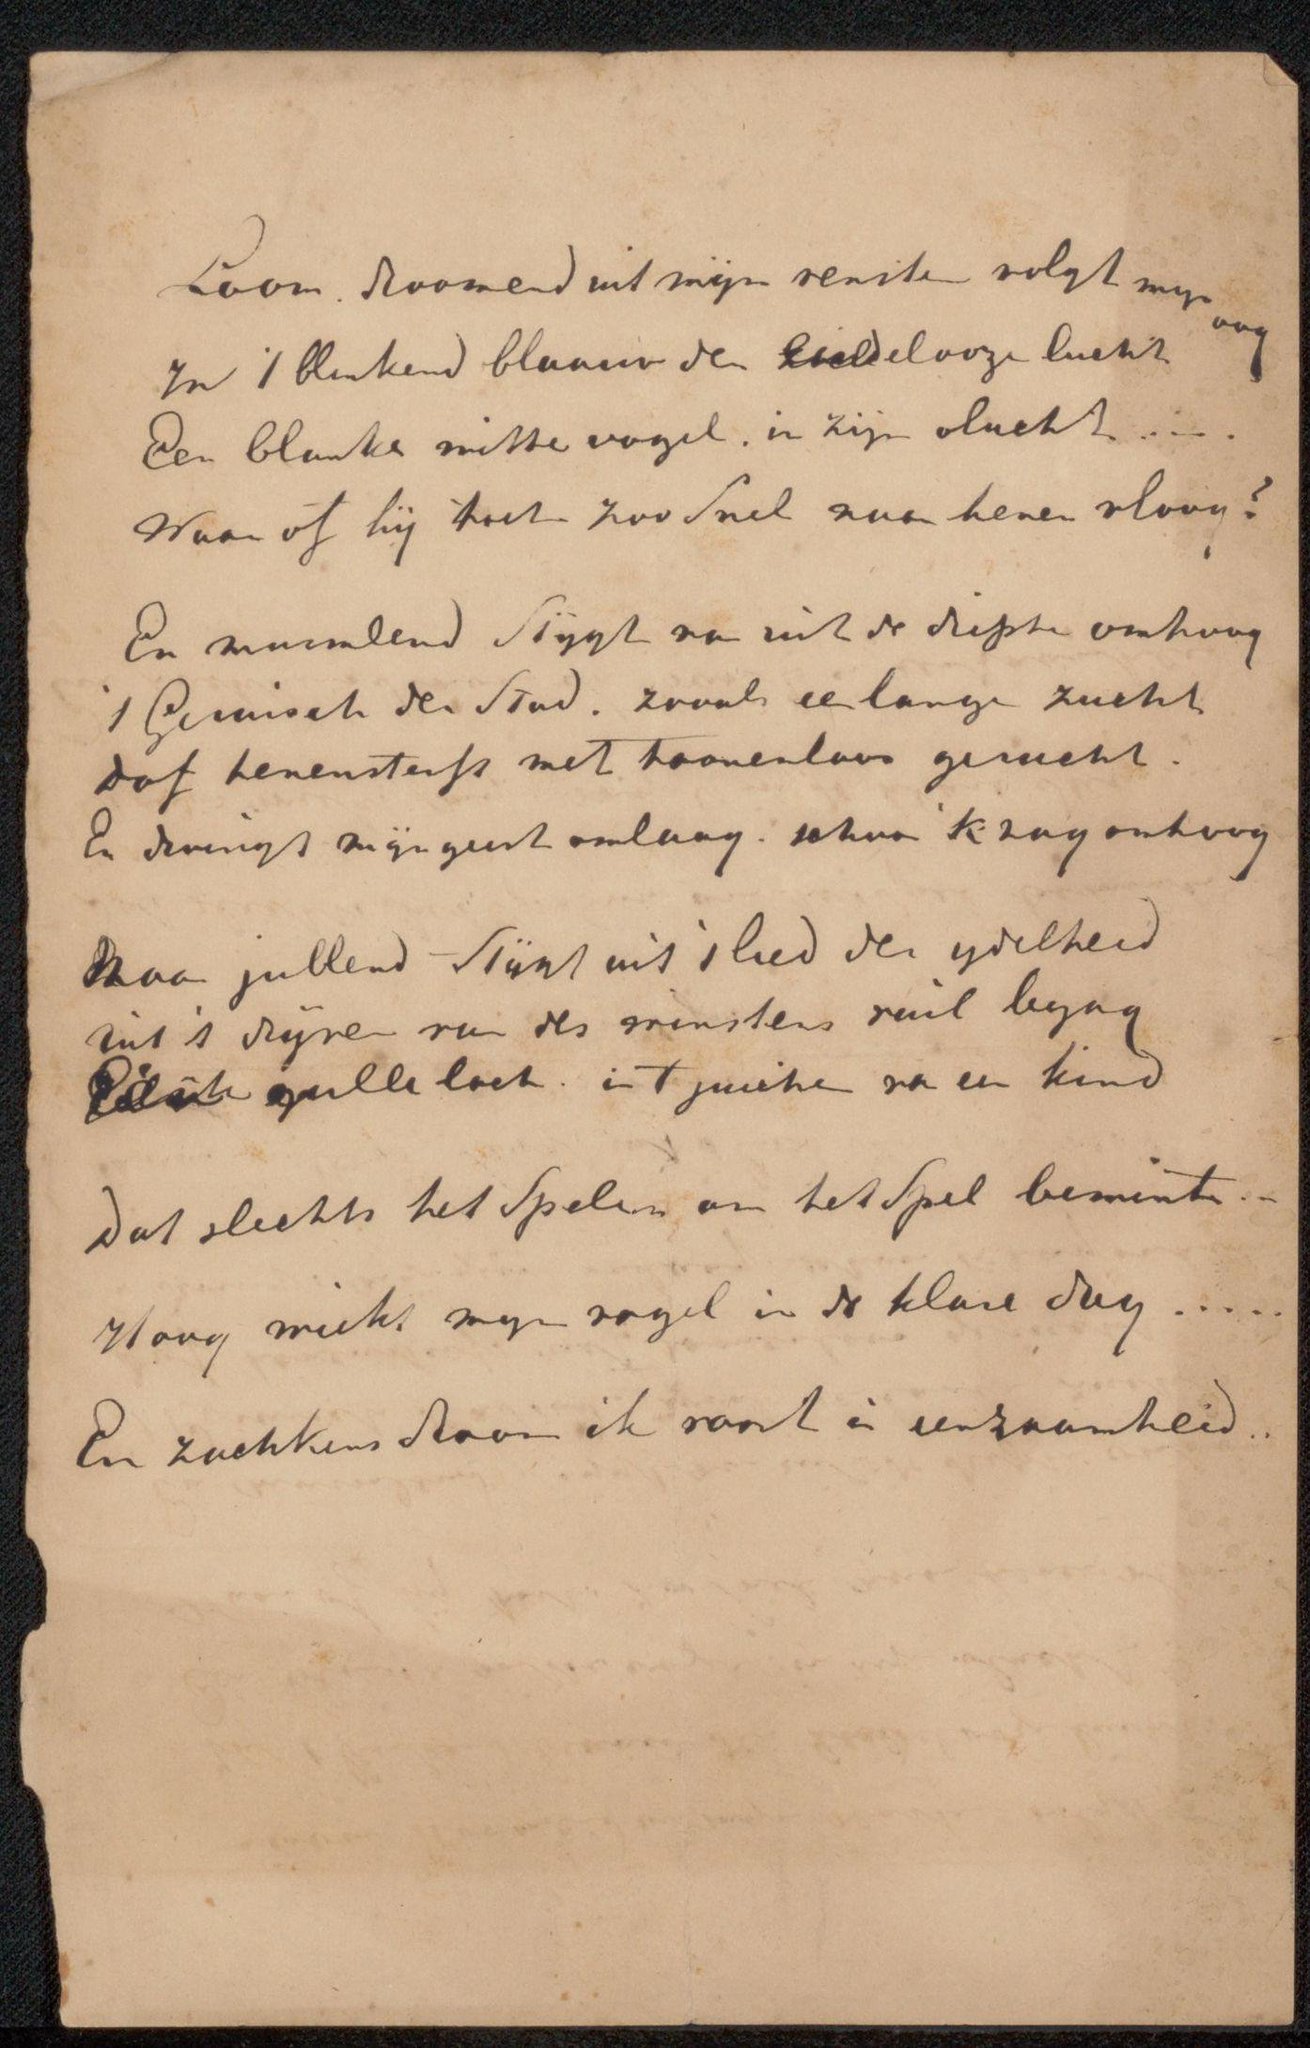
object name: poem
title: Gedicht uit archief Jan Veth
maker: jac van looij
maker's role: draughtsman, painter, print maker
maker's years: 1855-1930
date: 1865-1930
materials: ink, paper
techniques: pen, writing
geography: amsterdam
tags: dordrecht, painter, print maker, draughtsman, designer, jan veth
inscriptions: collector's mark: ‘RPK’